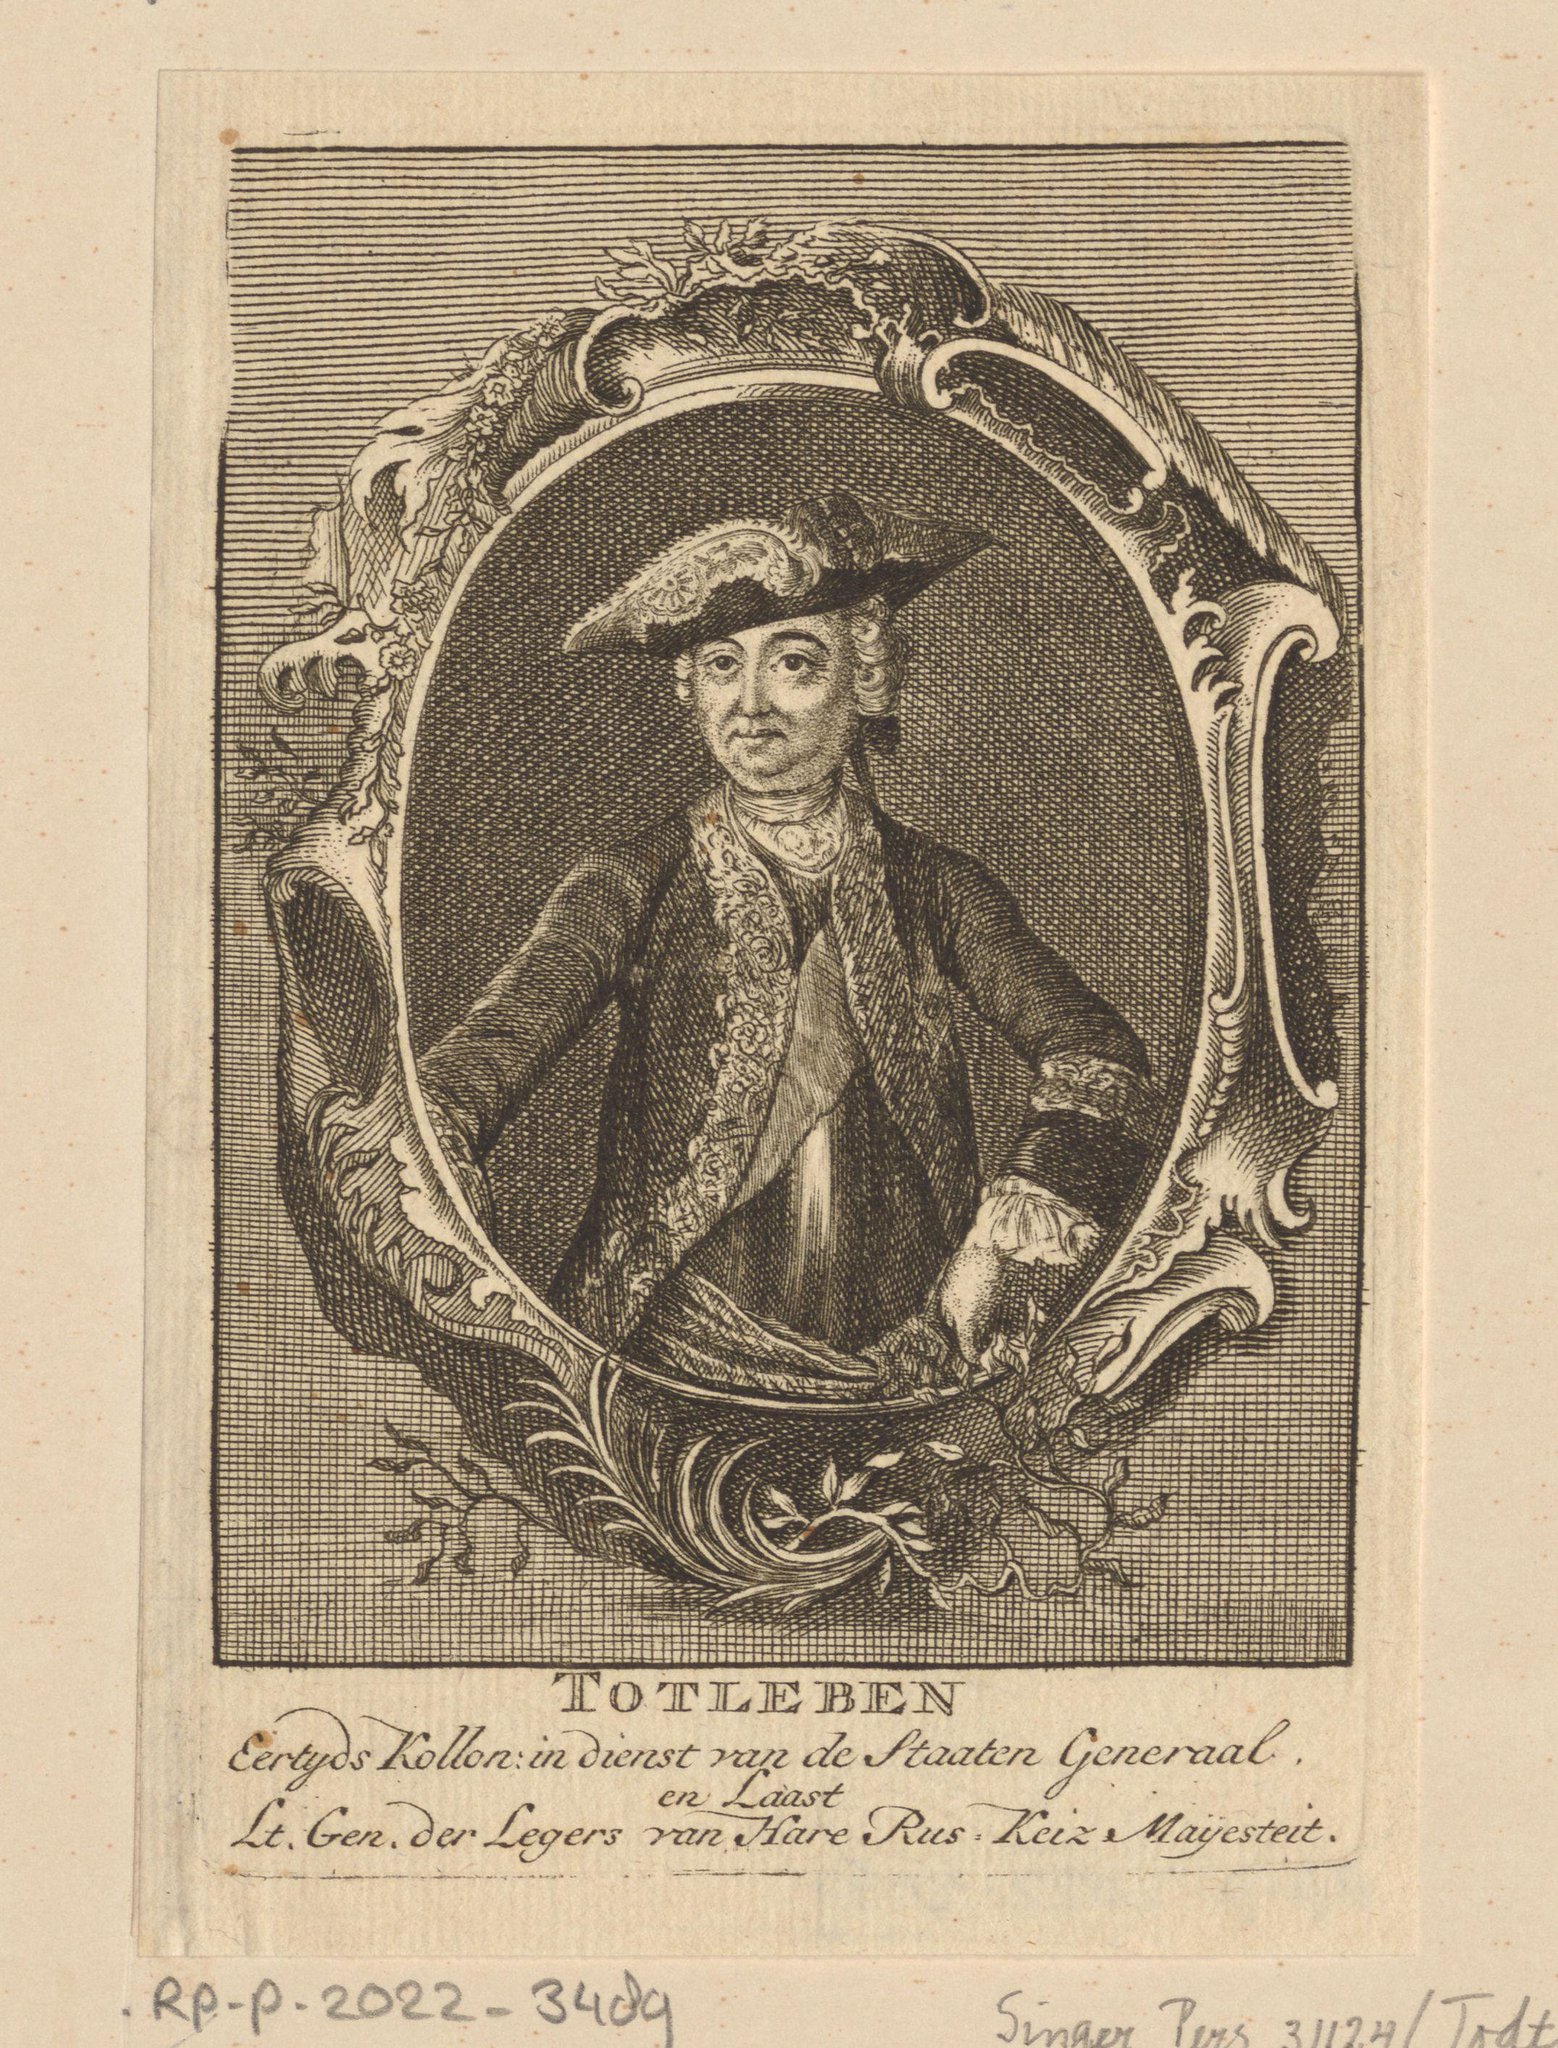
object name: print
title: Portret van Gottlob Heinrich Curt von Tottleben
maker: Anonymous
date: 1750-1800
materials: paper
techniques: etching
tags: germany, russia, commander-in-chief, general, marshal, historical persons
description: Met tweeregelig onderschrift in het Nederlands.